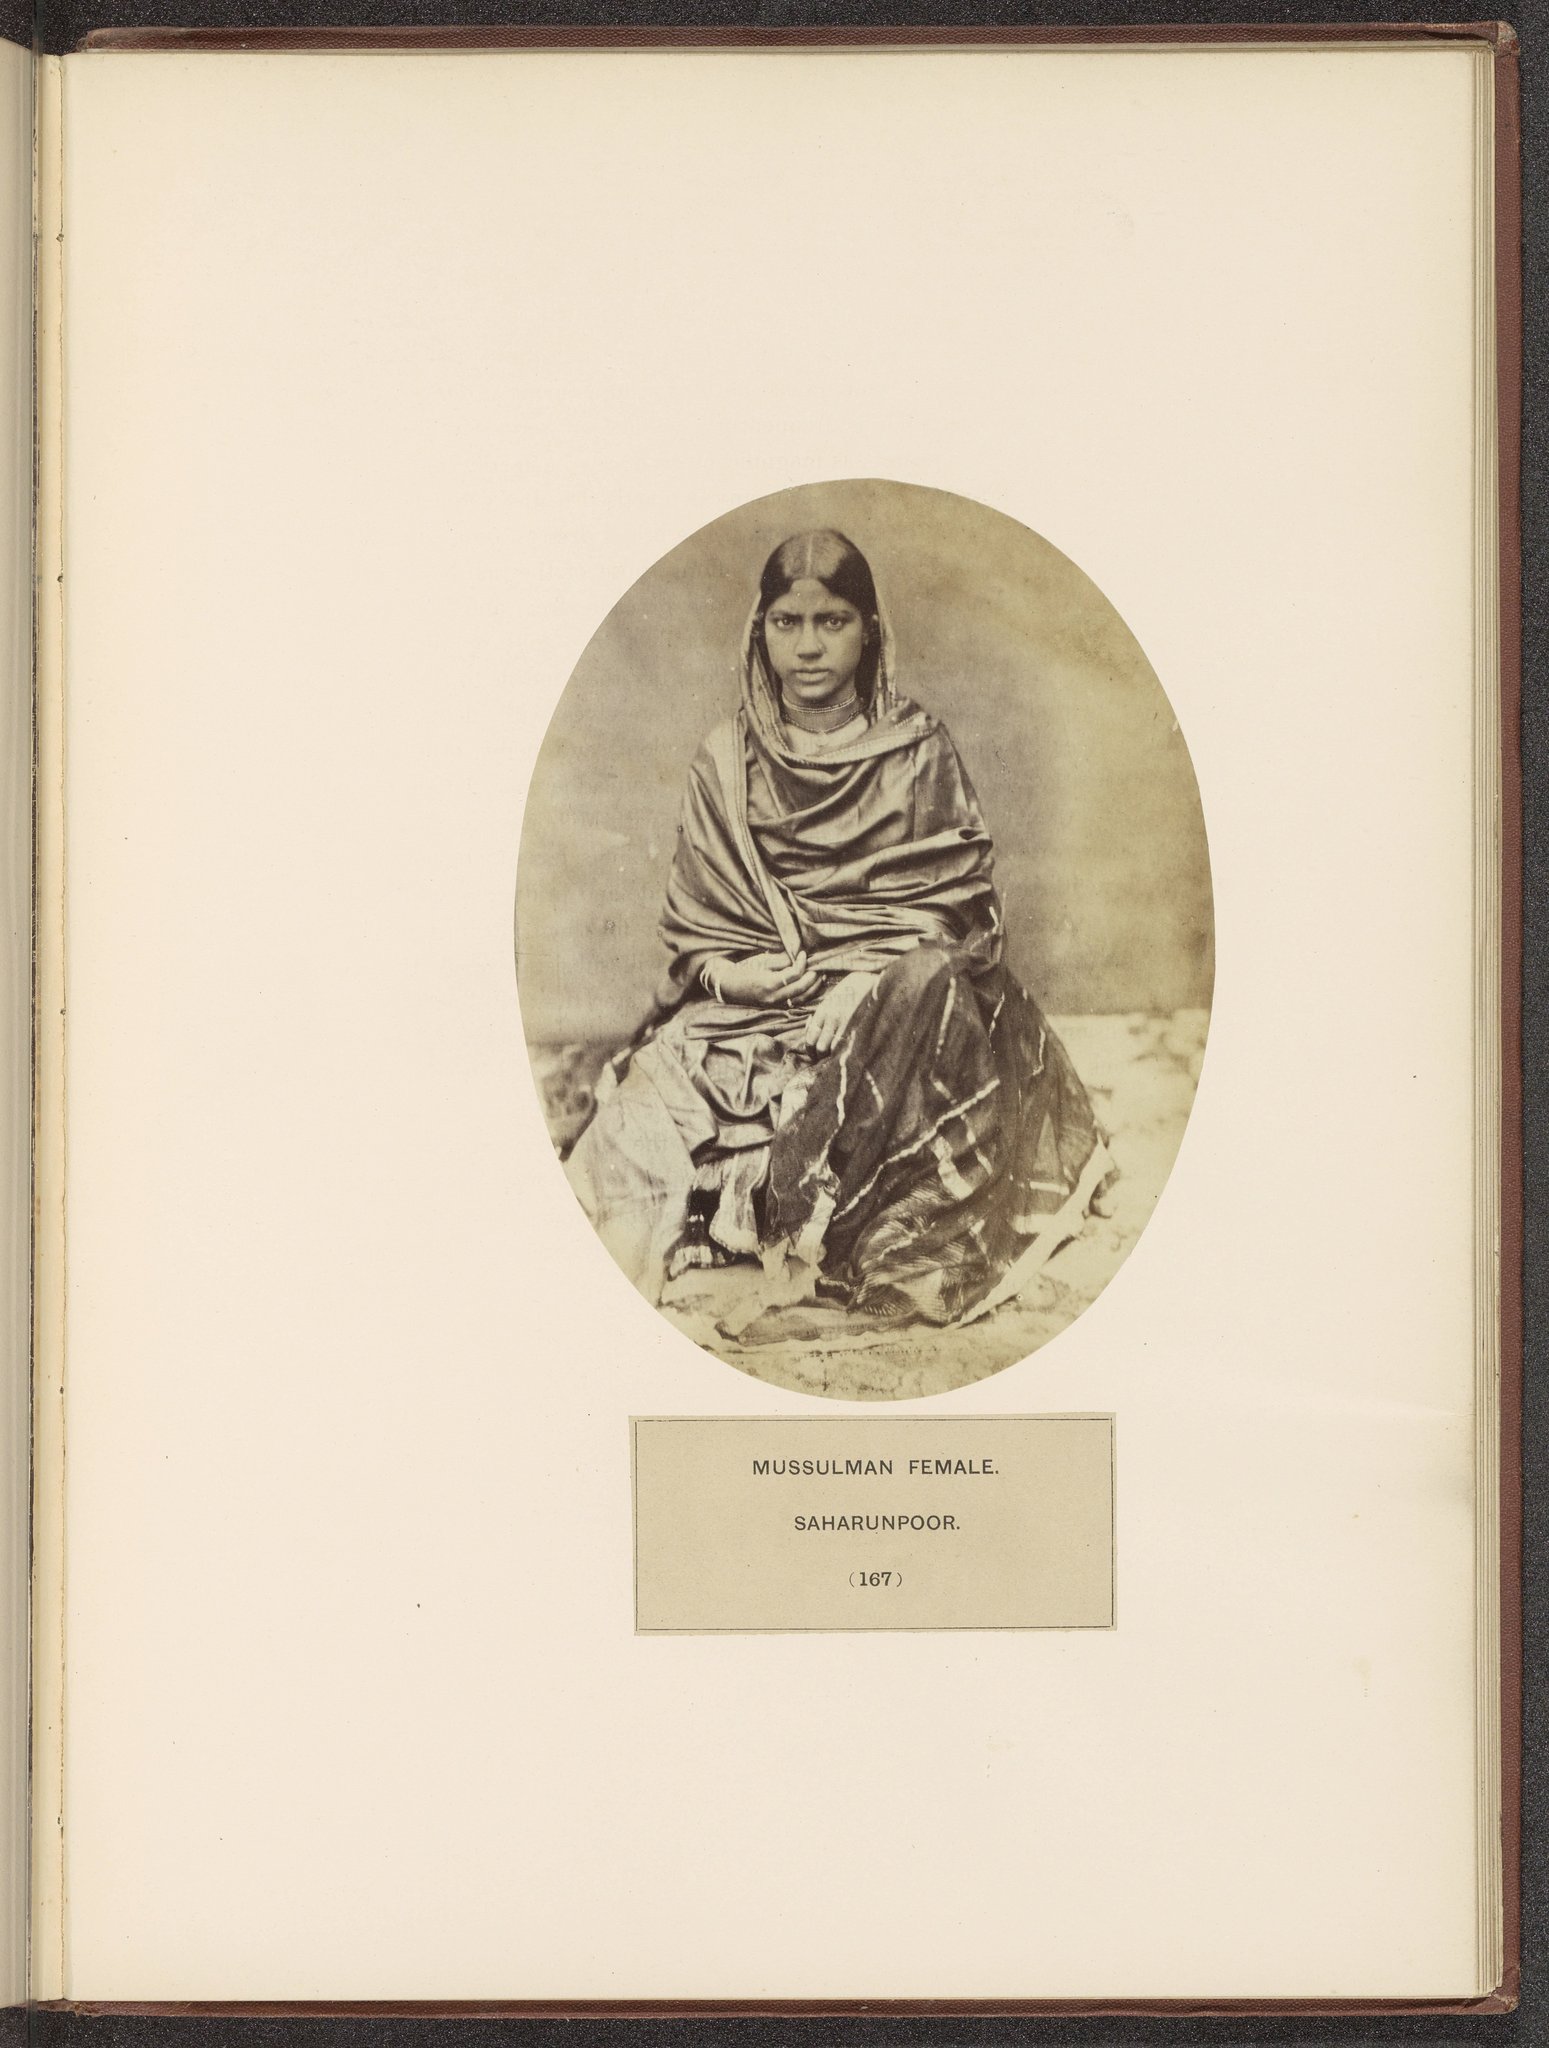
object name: photograph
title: Portrait of an unknown Muslim woman from Haridwar, Uttarakhand, India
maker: Anonymous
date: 1858-1868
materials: photographic support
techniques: albumen print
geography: haridwar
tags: human races; peoples; nationalities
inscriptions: number: ‘(167)’, inscription: ‘MUSSULMAN FEMALE./ SAHARUNPOOR.’